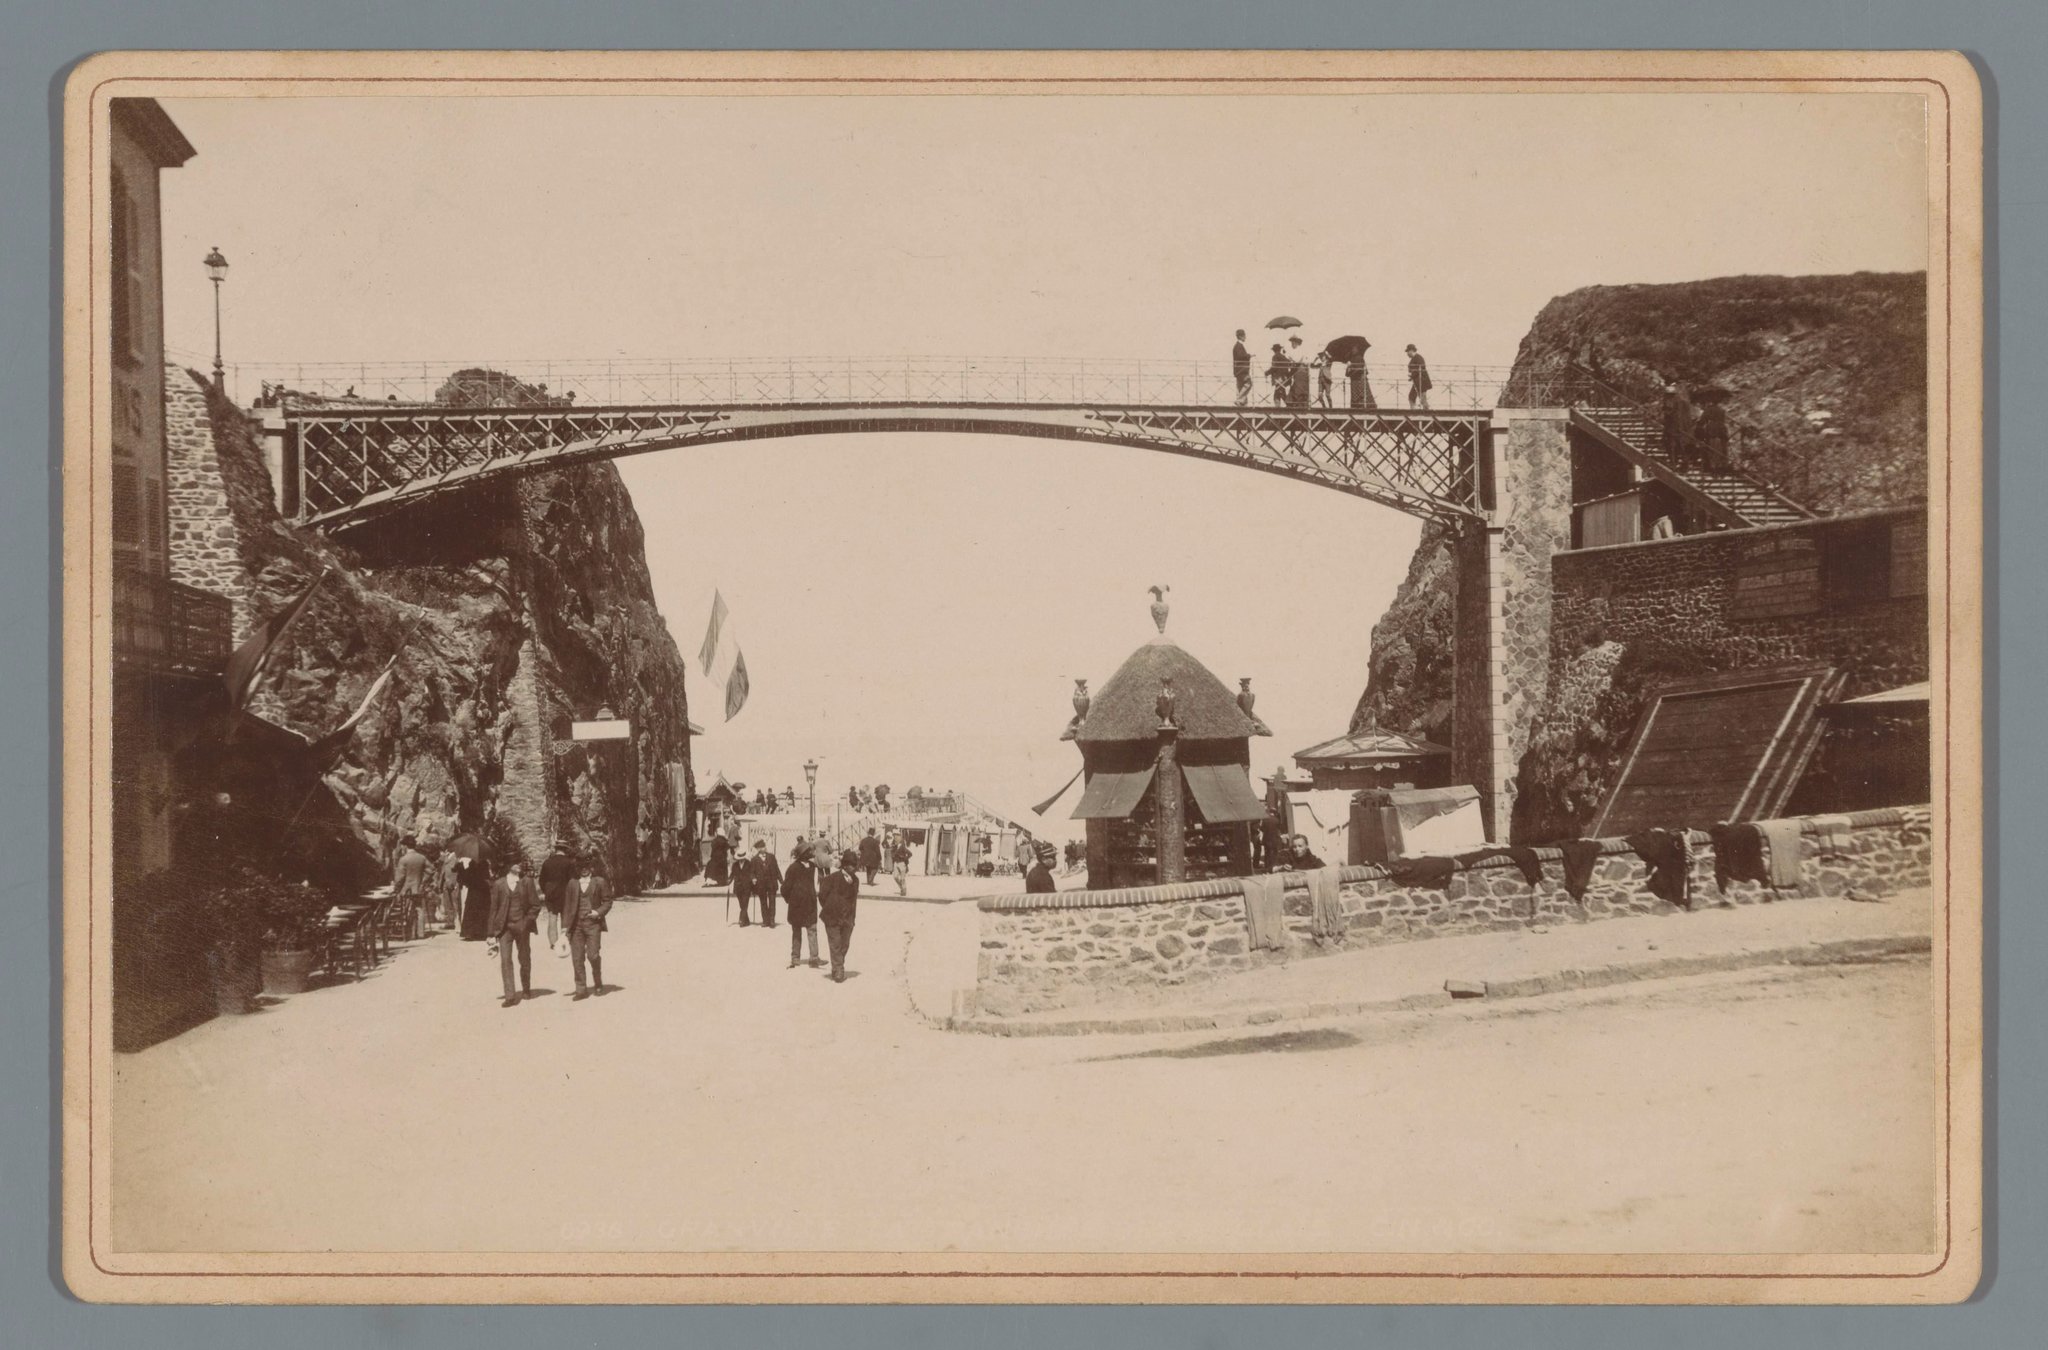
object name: cabinet photograph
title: Gezicht op een loopbrug bij een strand in Normandië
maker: Anonymous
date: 1880-1945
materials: cardboard, photographic support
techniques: gelatin silver print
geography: normandy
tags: public convenience, beach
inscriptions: annotation: ‘Normandië [...]’